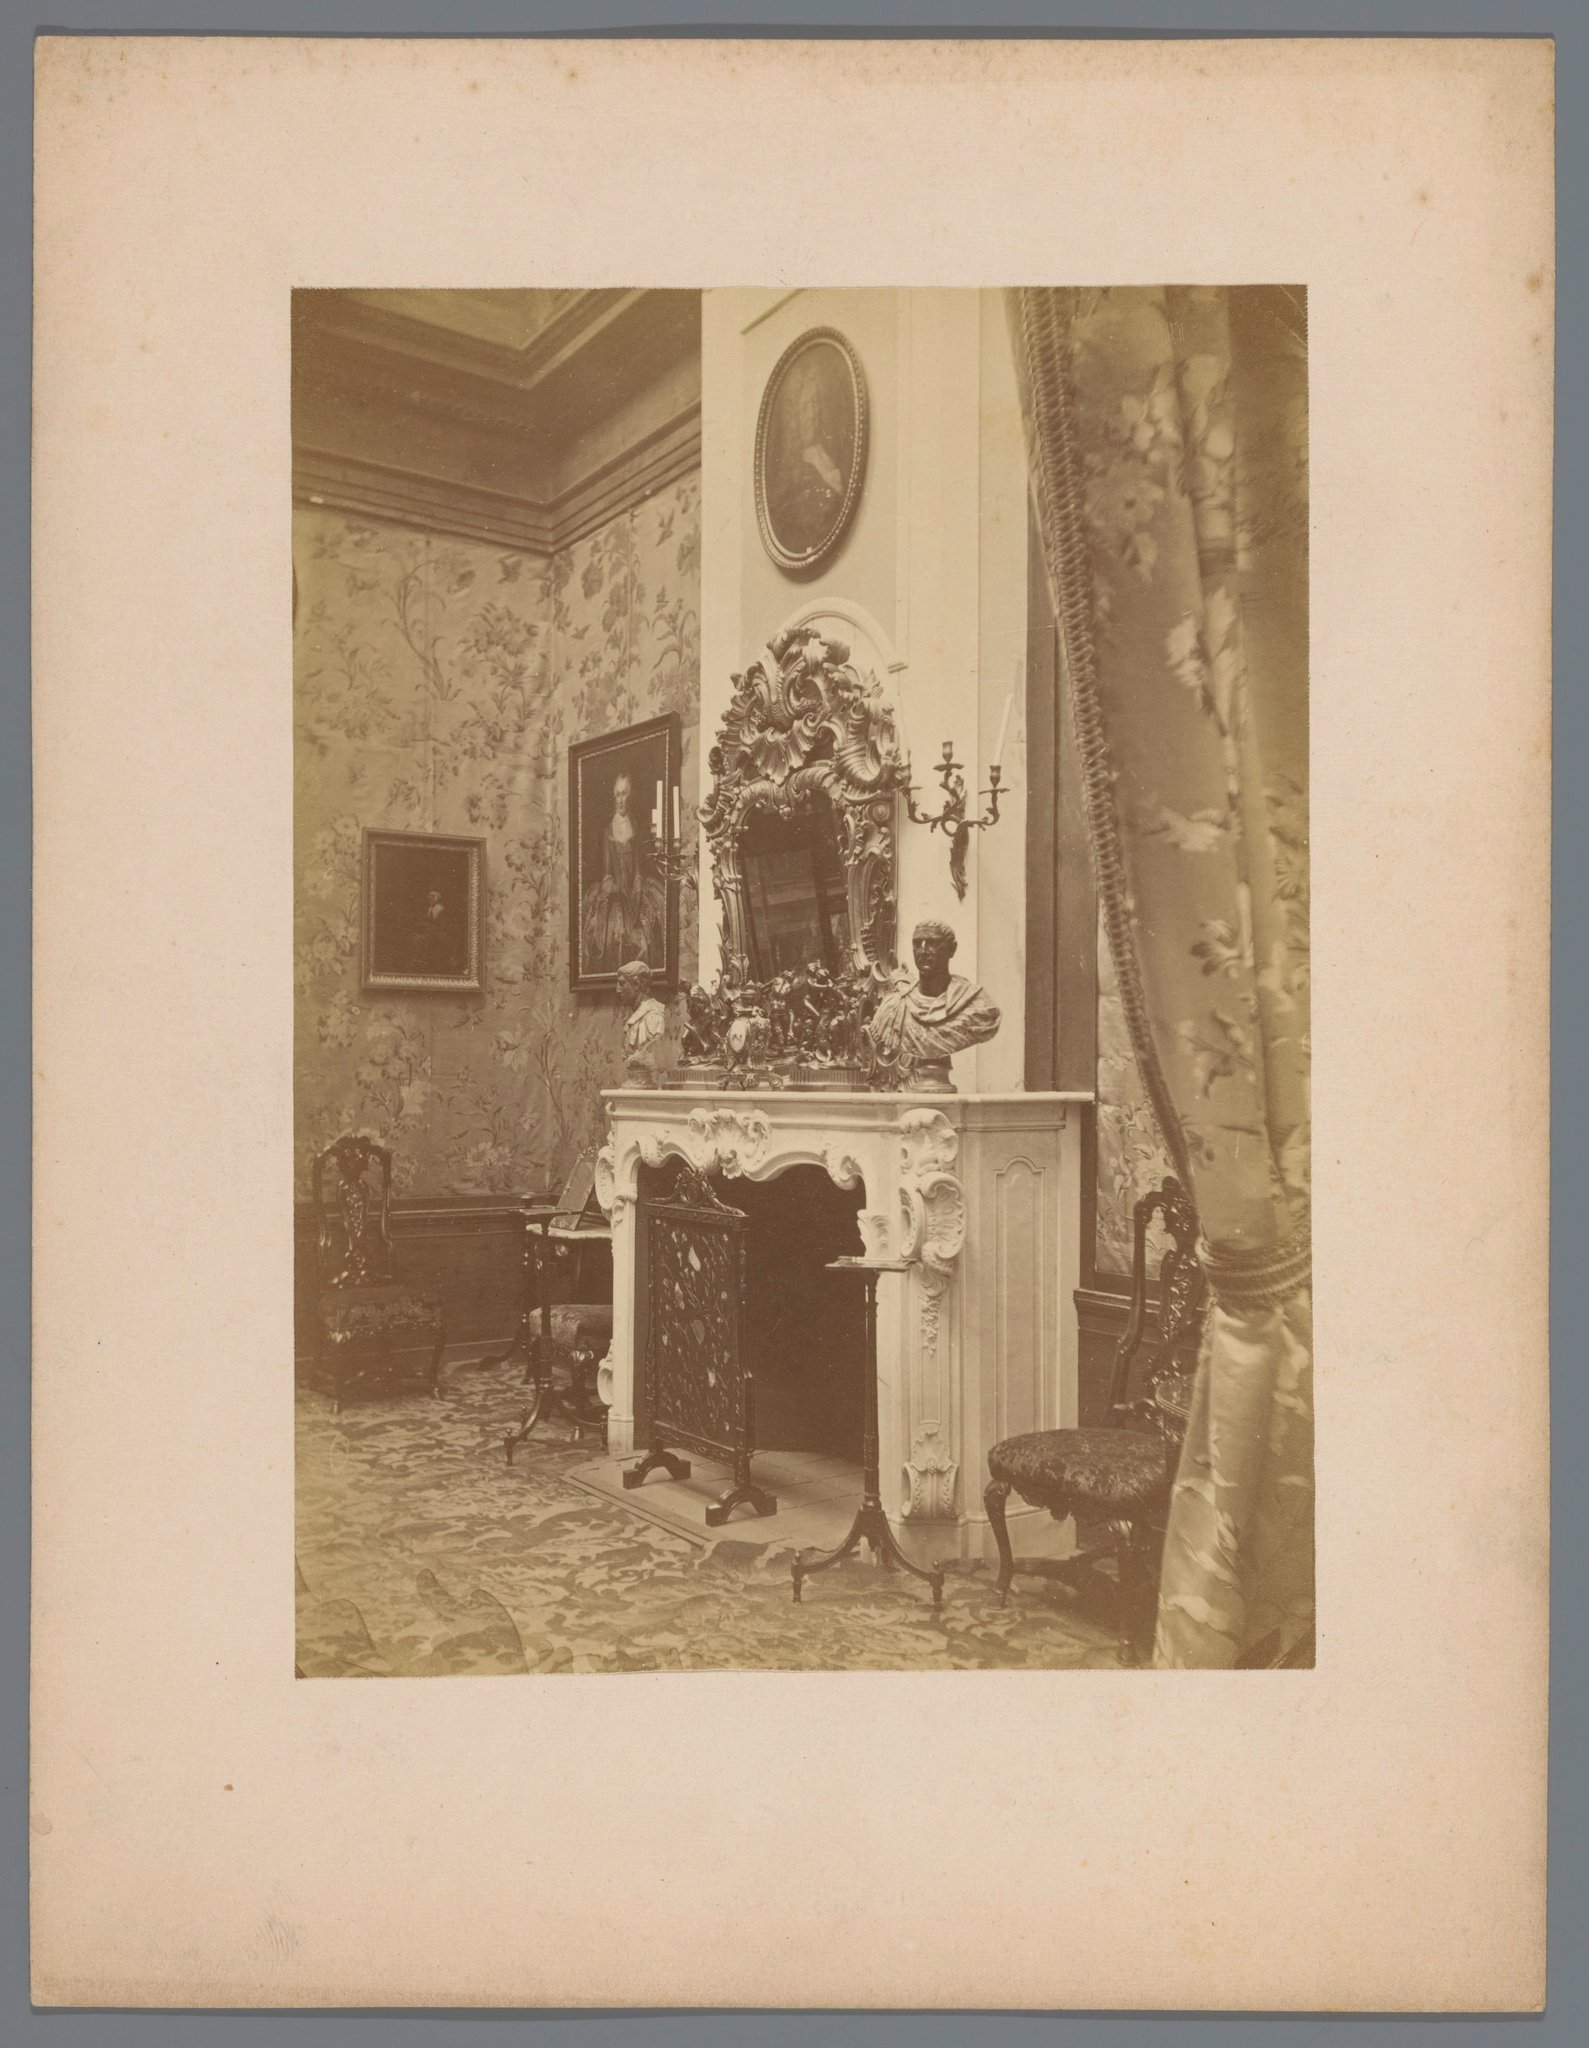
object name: photograph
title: Interieur met een schouw en meubilair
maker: pieter oosterhuis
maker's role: draughtsman, print maker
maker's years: 1816-1885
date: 1875-1885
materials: cardboard, photographic support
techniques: albumen print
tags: seating furniture, chest, bust, mirror, open hearth, fire-place, interior of the house, picture, painting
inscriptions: collector's mark: Lugt 3937, name: ‘PHOT-P.OOSTERHUIS’